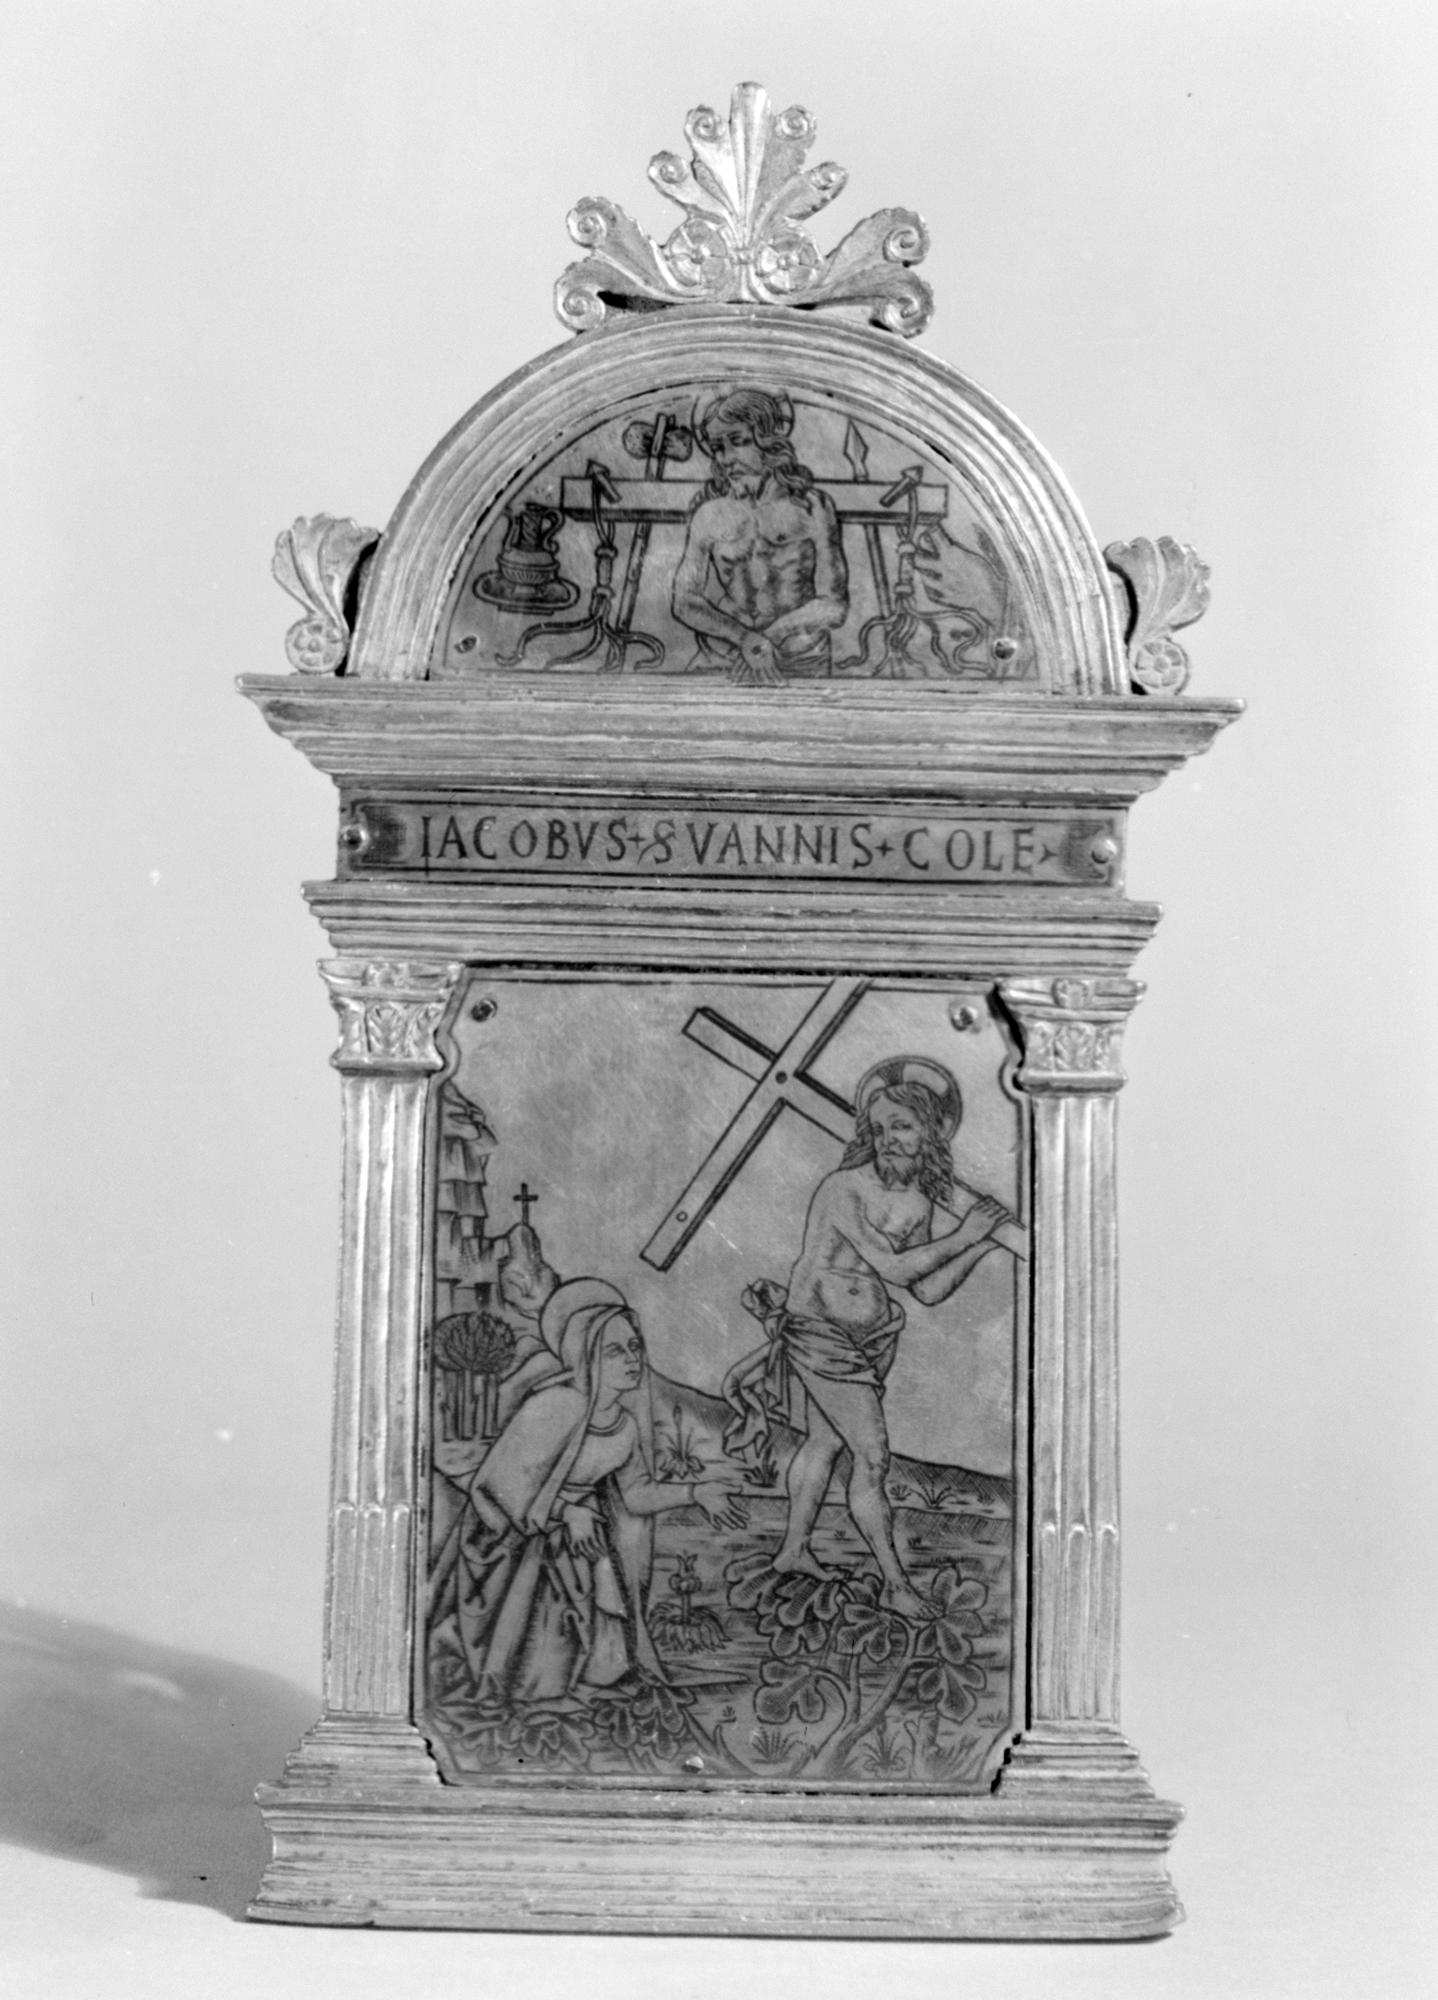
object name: pax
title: Christ and the Virgin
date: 1476-1500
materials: gilt bronze, niello, silver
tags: christ,virgin mary,cross